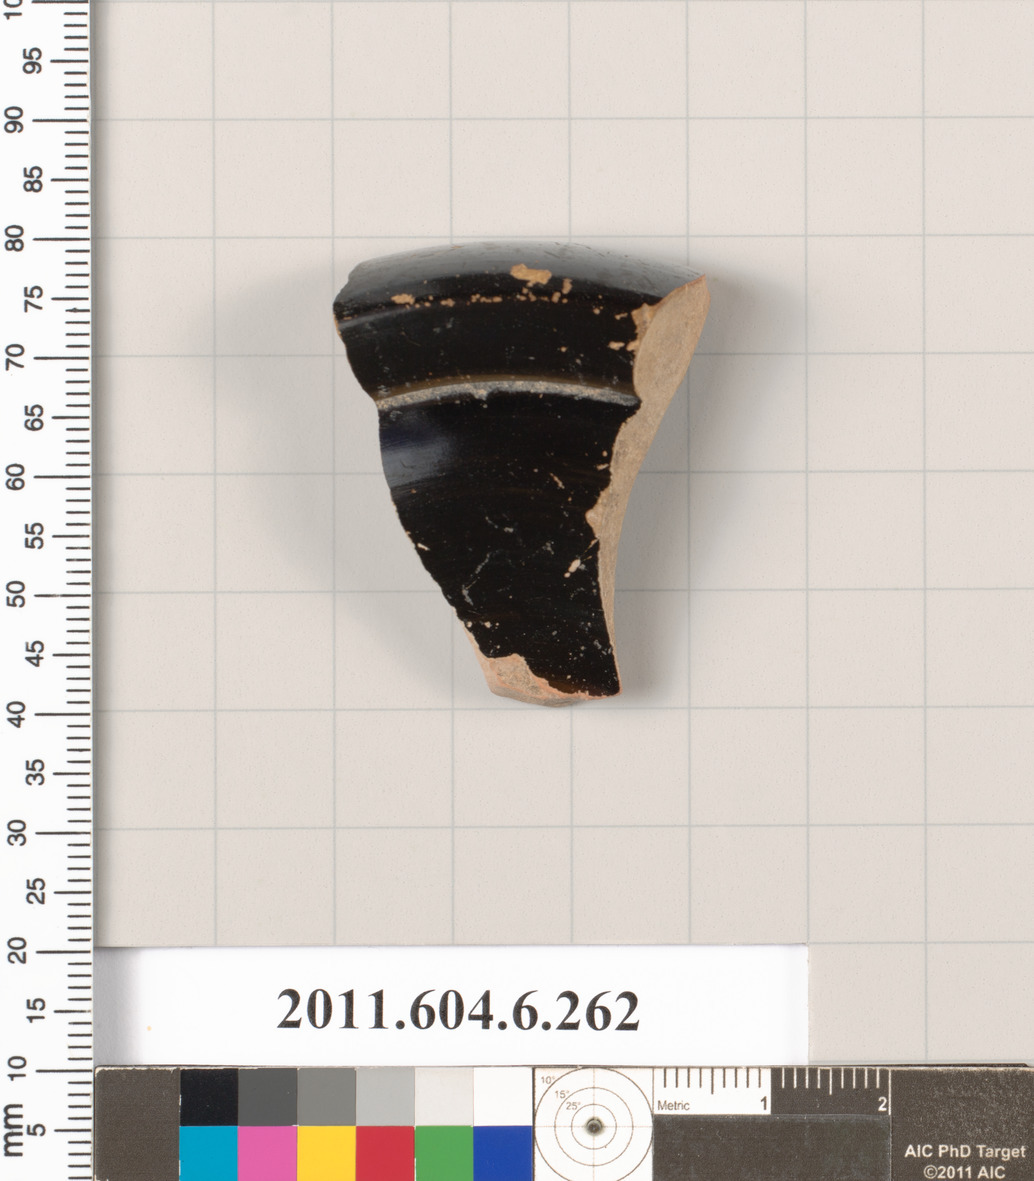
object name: stemmed dish fragment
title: Terracotta fragment of a stemmed dish?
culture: greek, attic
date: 500-401 BCE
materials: terracotta